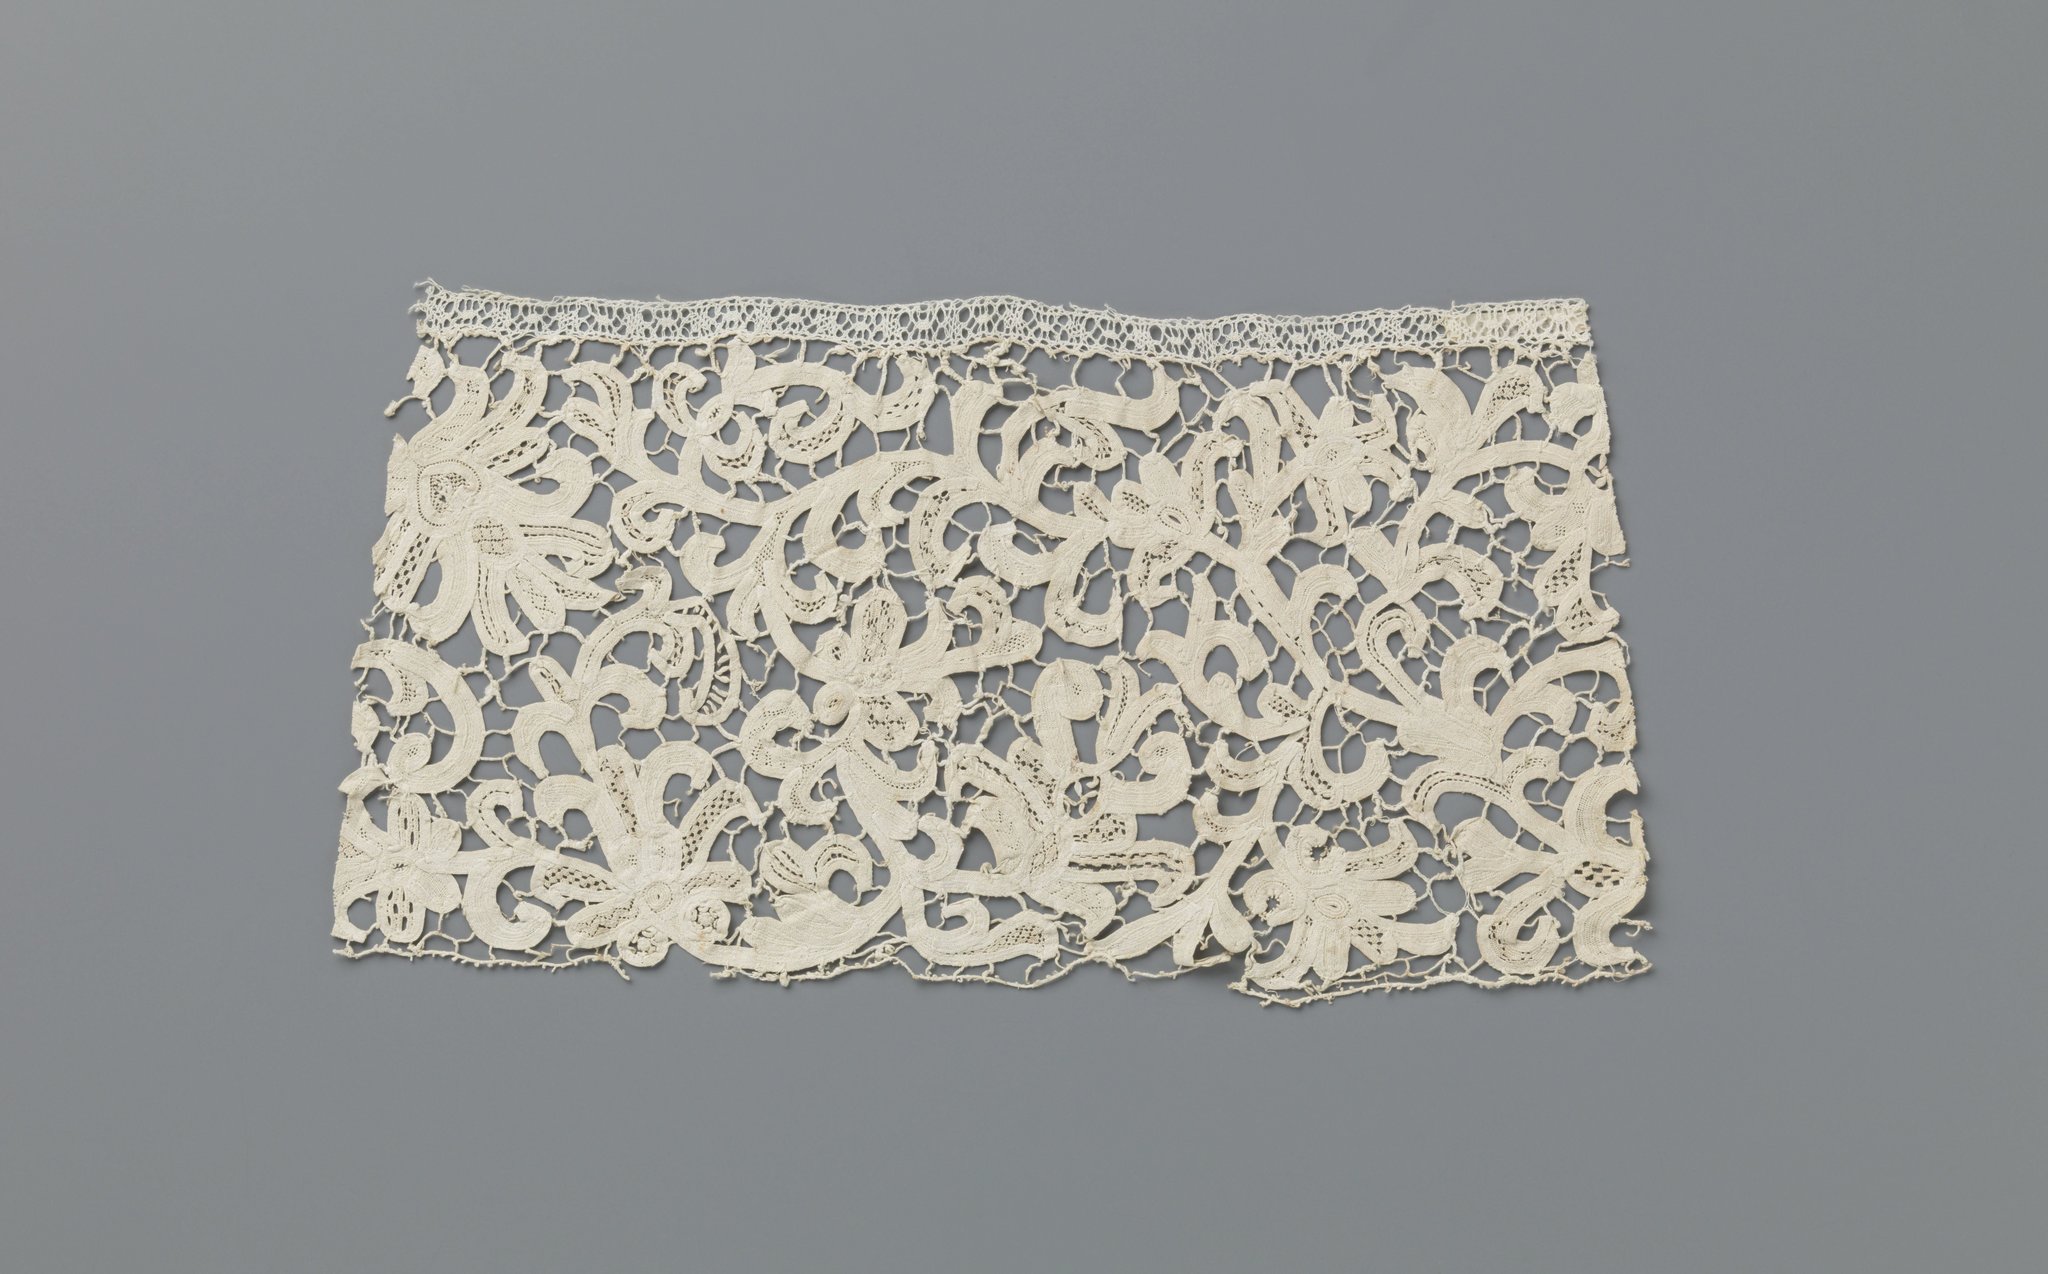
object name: strip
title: Strook naaldkant met irissen aan voluutranken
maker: Anonymous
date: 1650-1699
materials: linen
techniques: lace, weave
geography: venice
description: Strook naturelkleurige gemengde kant: Venetiaanse lintjeskant. Patroon van voluutranken, met verschillende irisachtige bloemen op een onregelmatige, open spijlengrond. De spijlen zijn apart gemaakt en als verbinding tussen de ranken en bloemen vast genaaid. De contouren van het patroon worden gevormd door een schuin geweven en daardoor rekbaar lint. Binnen de contouren en ook binnen de afzonderlijke bloemen verschillende siergronden door uitsparingen in het volwerk. De bovenzijde is afgezet met een rand kloskant. De onderzijde is afgewerkt met een rechte picotrand.